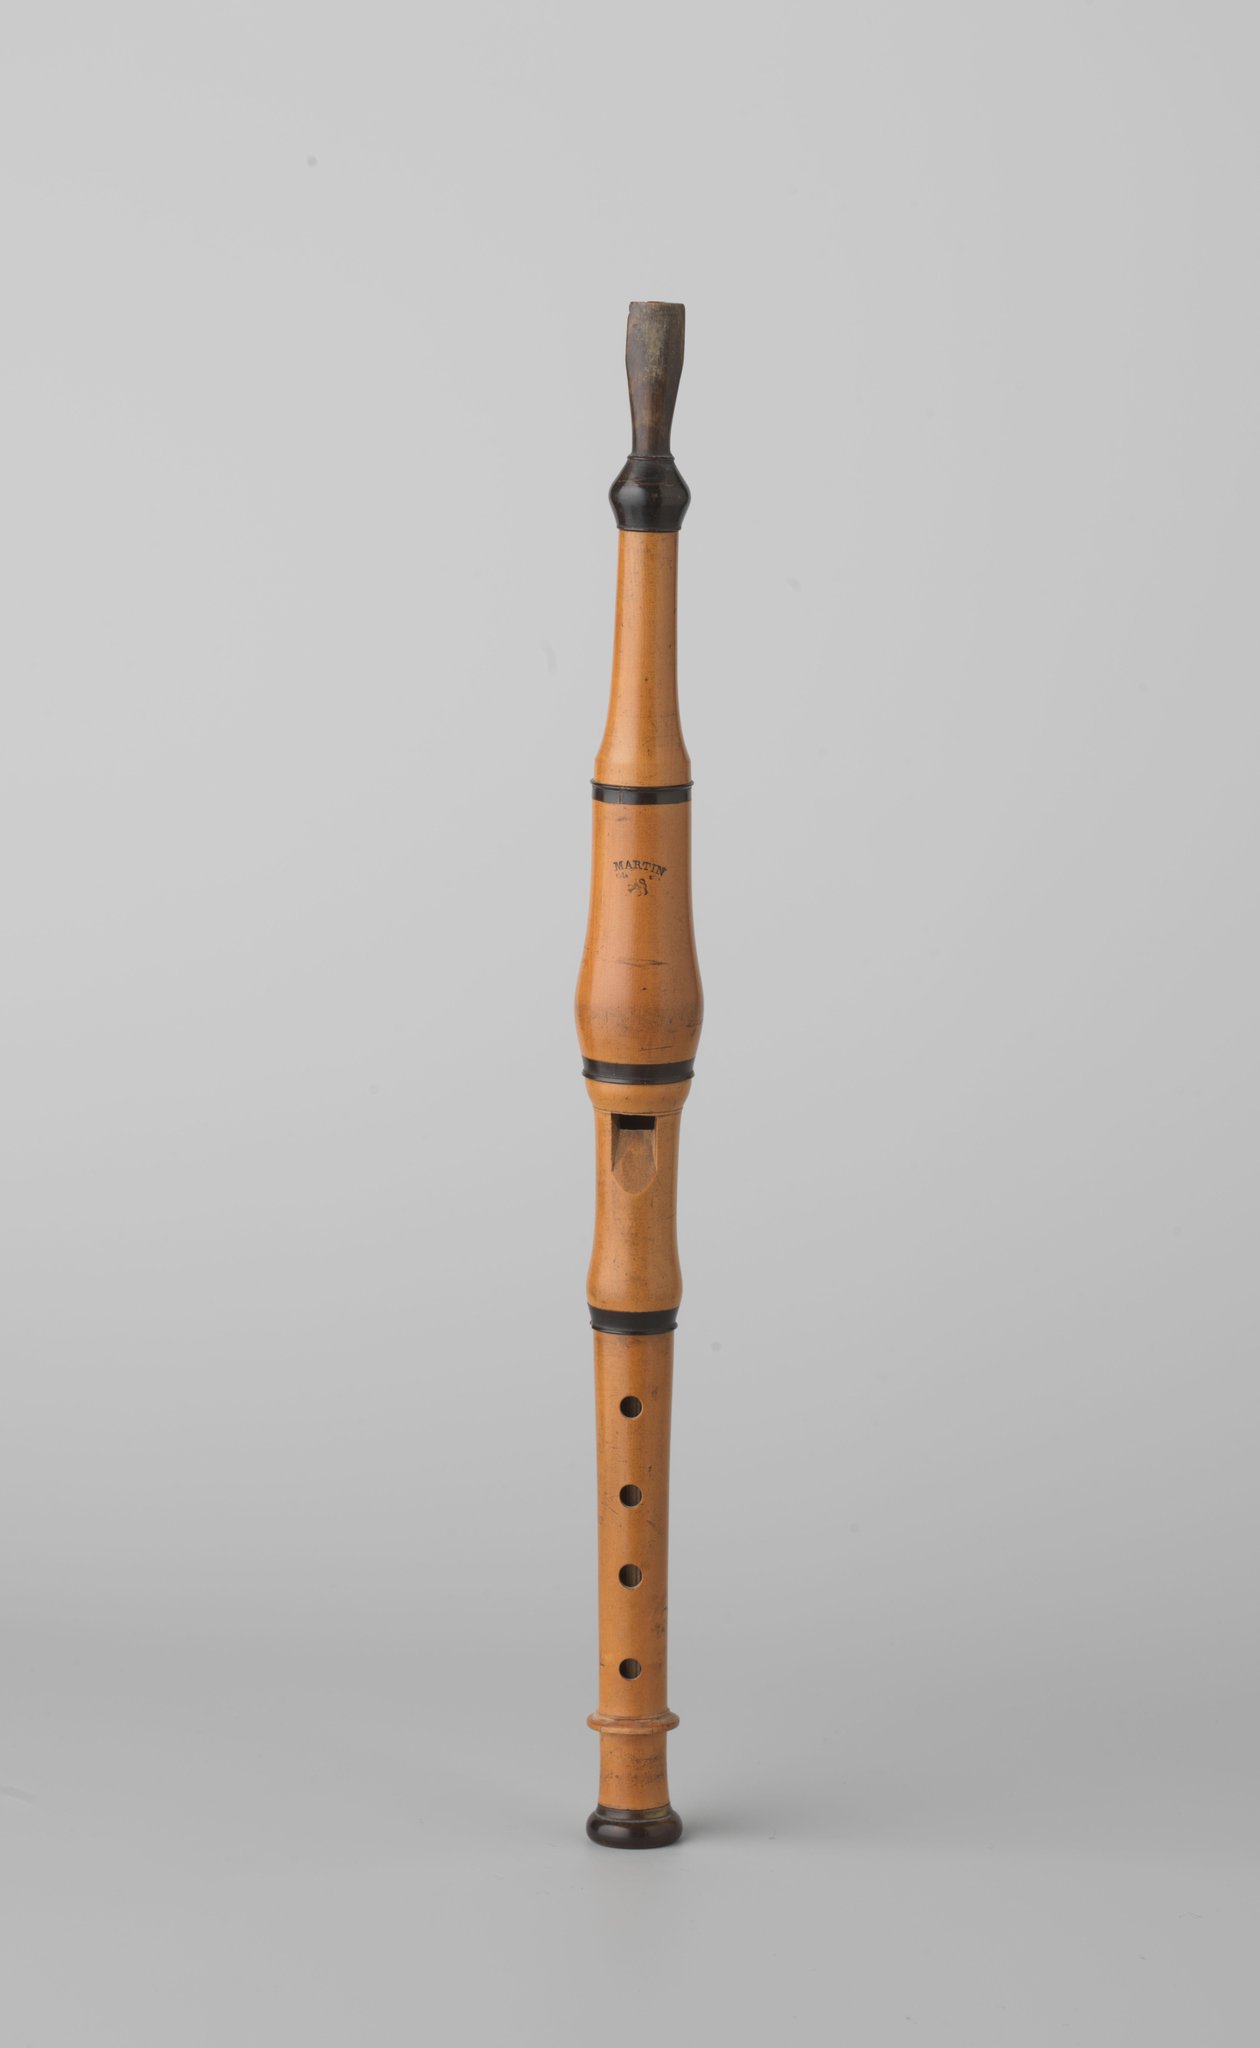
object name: franse flageolet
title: French flageolet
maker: martin (muziekinstrumentbouwer)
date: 1827-1880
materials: wood, horn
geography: la couture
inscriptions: : ‘MARTIN / [2 bloemen] / [klimmende leeuw]’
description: Vierdelige Franse flageolet (het bovenstuk bestaat uit twee delen + mondstuk) in buxus met ringen van hoorn. De houten ring onder het vierde voorste vingergat is iets afgebroken, maar verder is het fluitje gaaf bewaard. Bij een stemming van a-440 Hz klinkt de laagste toon als een as.